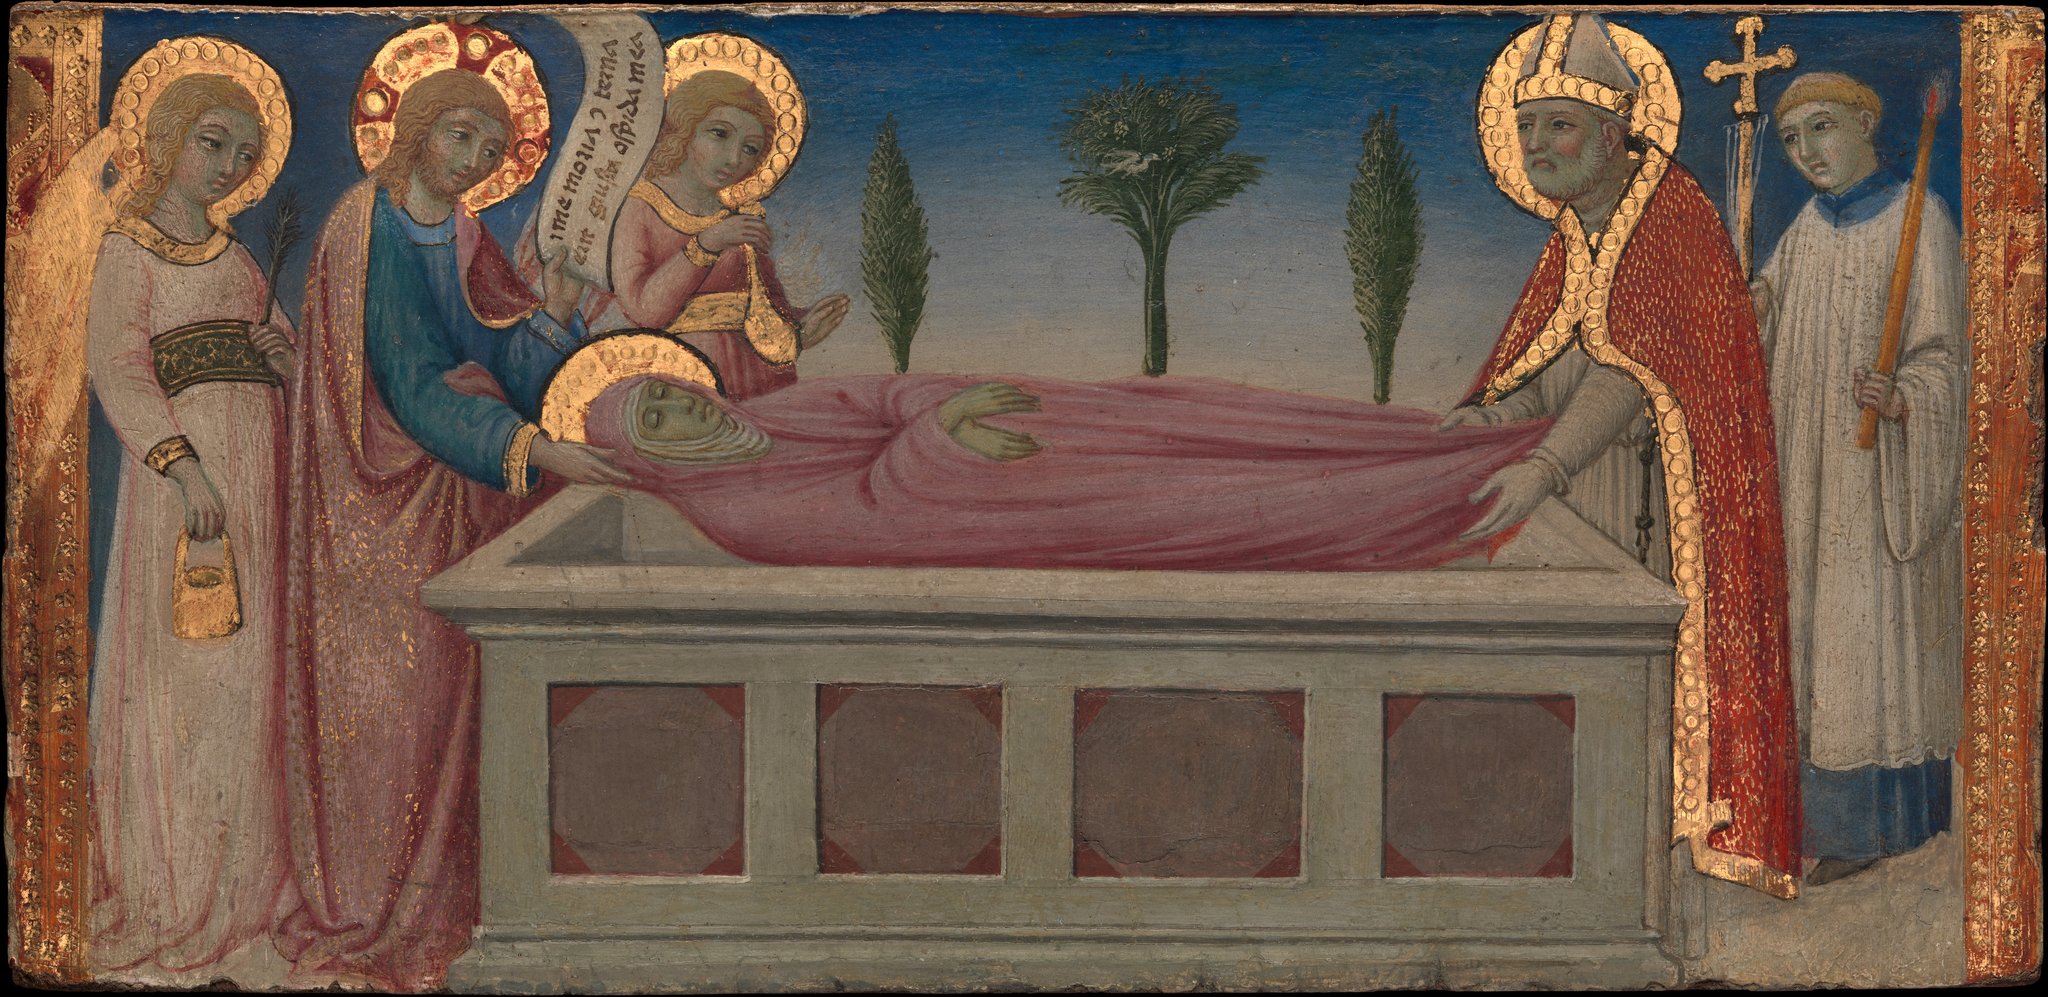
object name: painting, predella panel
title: The Burial of Saint Martha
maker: sano di pietro (ansano di pietro di mencio)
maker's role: artist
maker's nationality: italian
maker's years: 1405-1481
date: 1460-1470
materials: gold, paint, wood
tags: women,angels,saints,burials